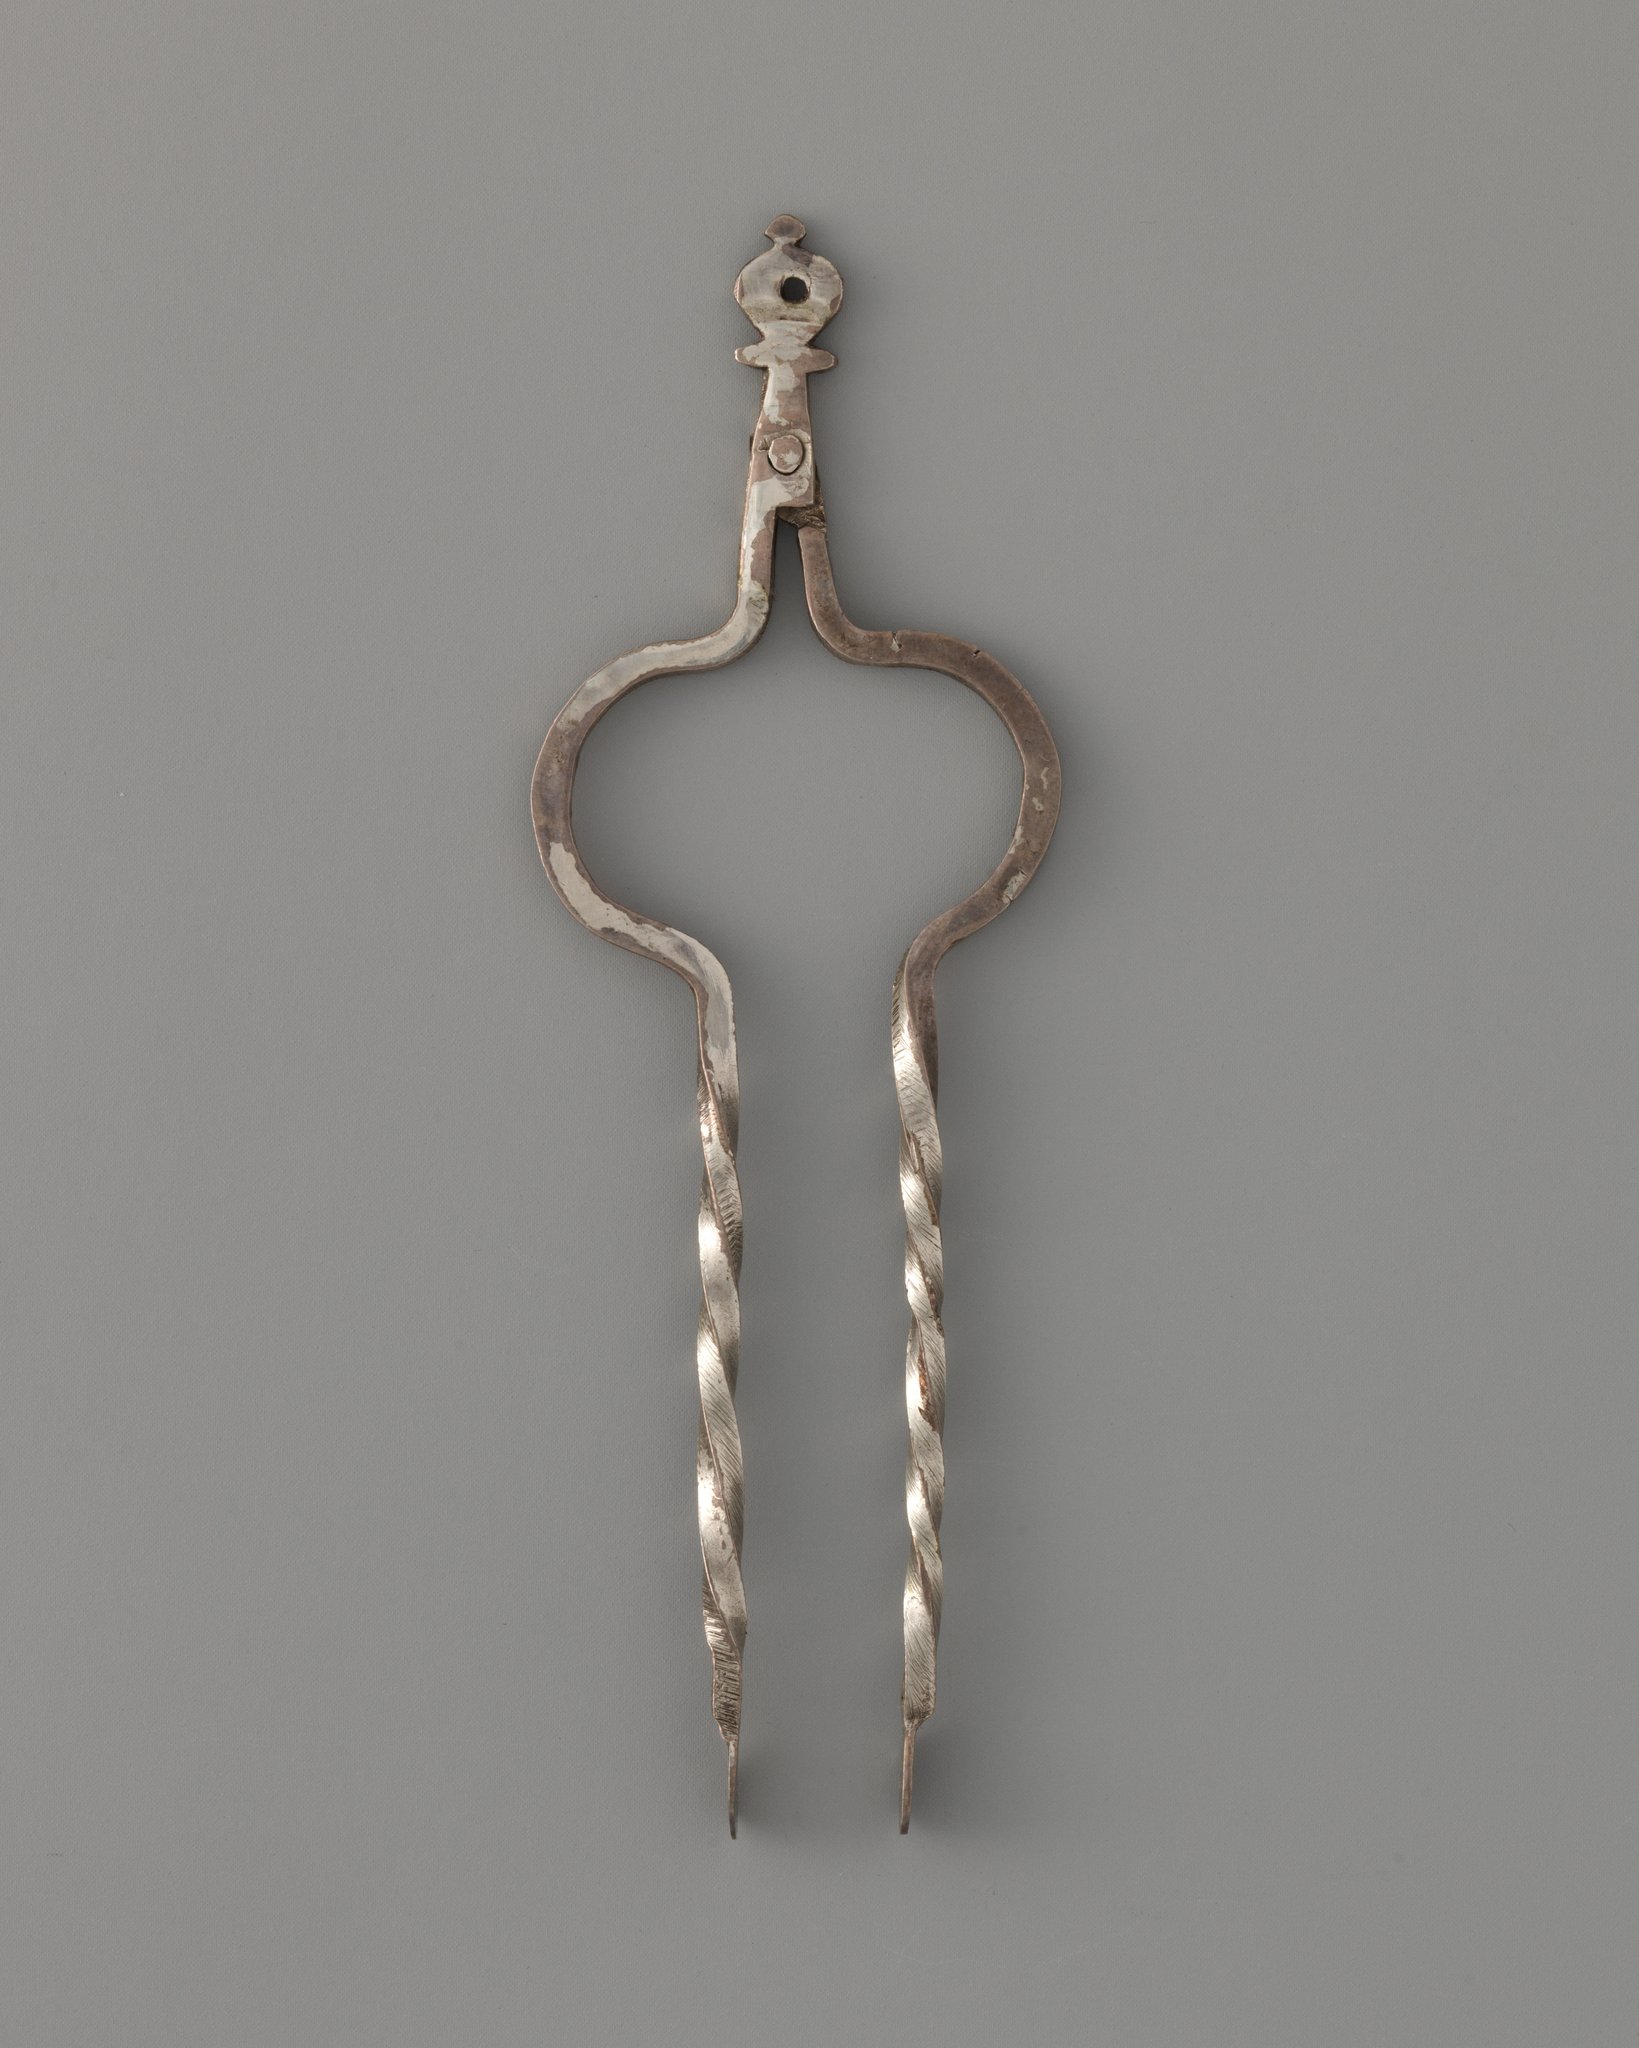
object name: tongs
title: Miniature tongs (part of a set)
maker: george manjoy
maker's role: maker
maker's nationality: british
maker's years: 1685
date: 1690-1691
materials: silver